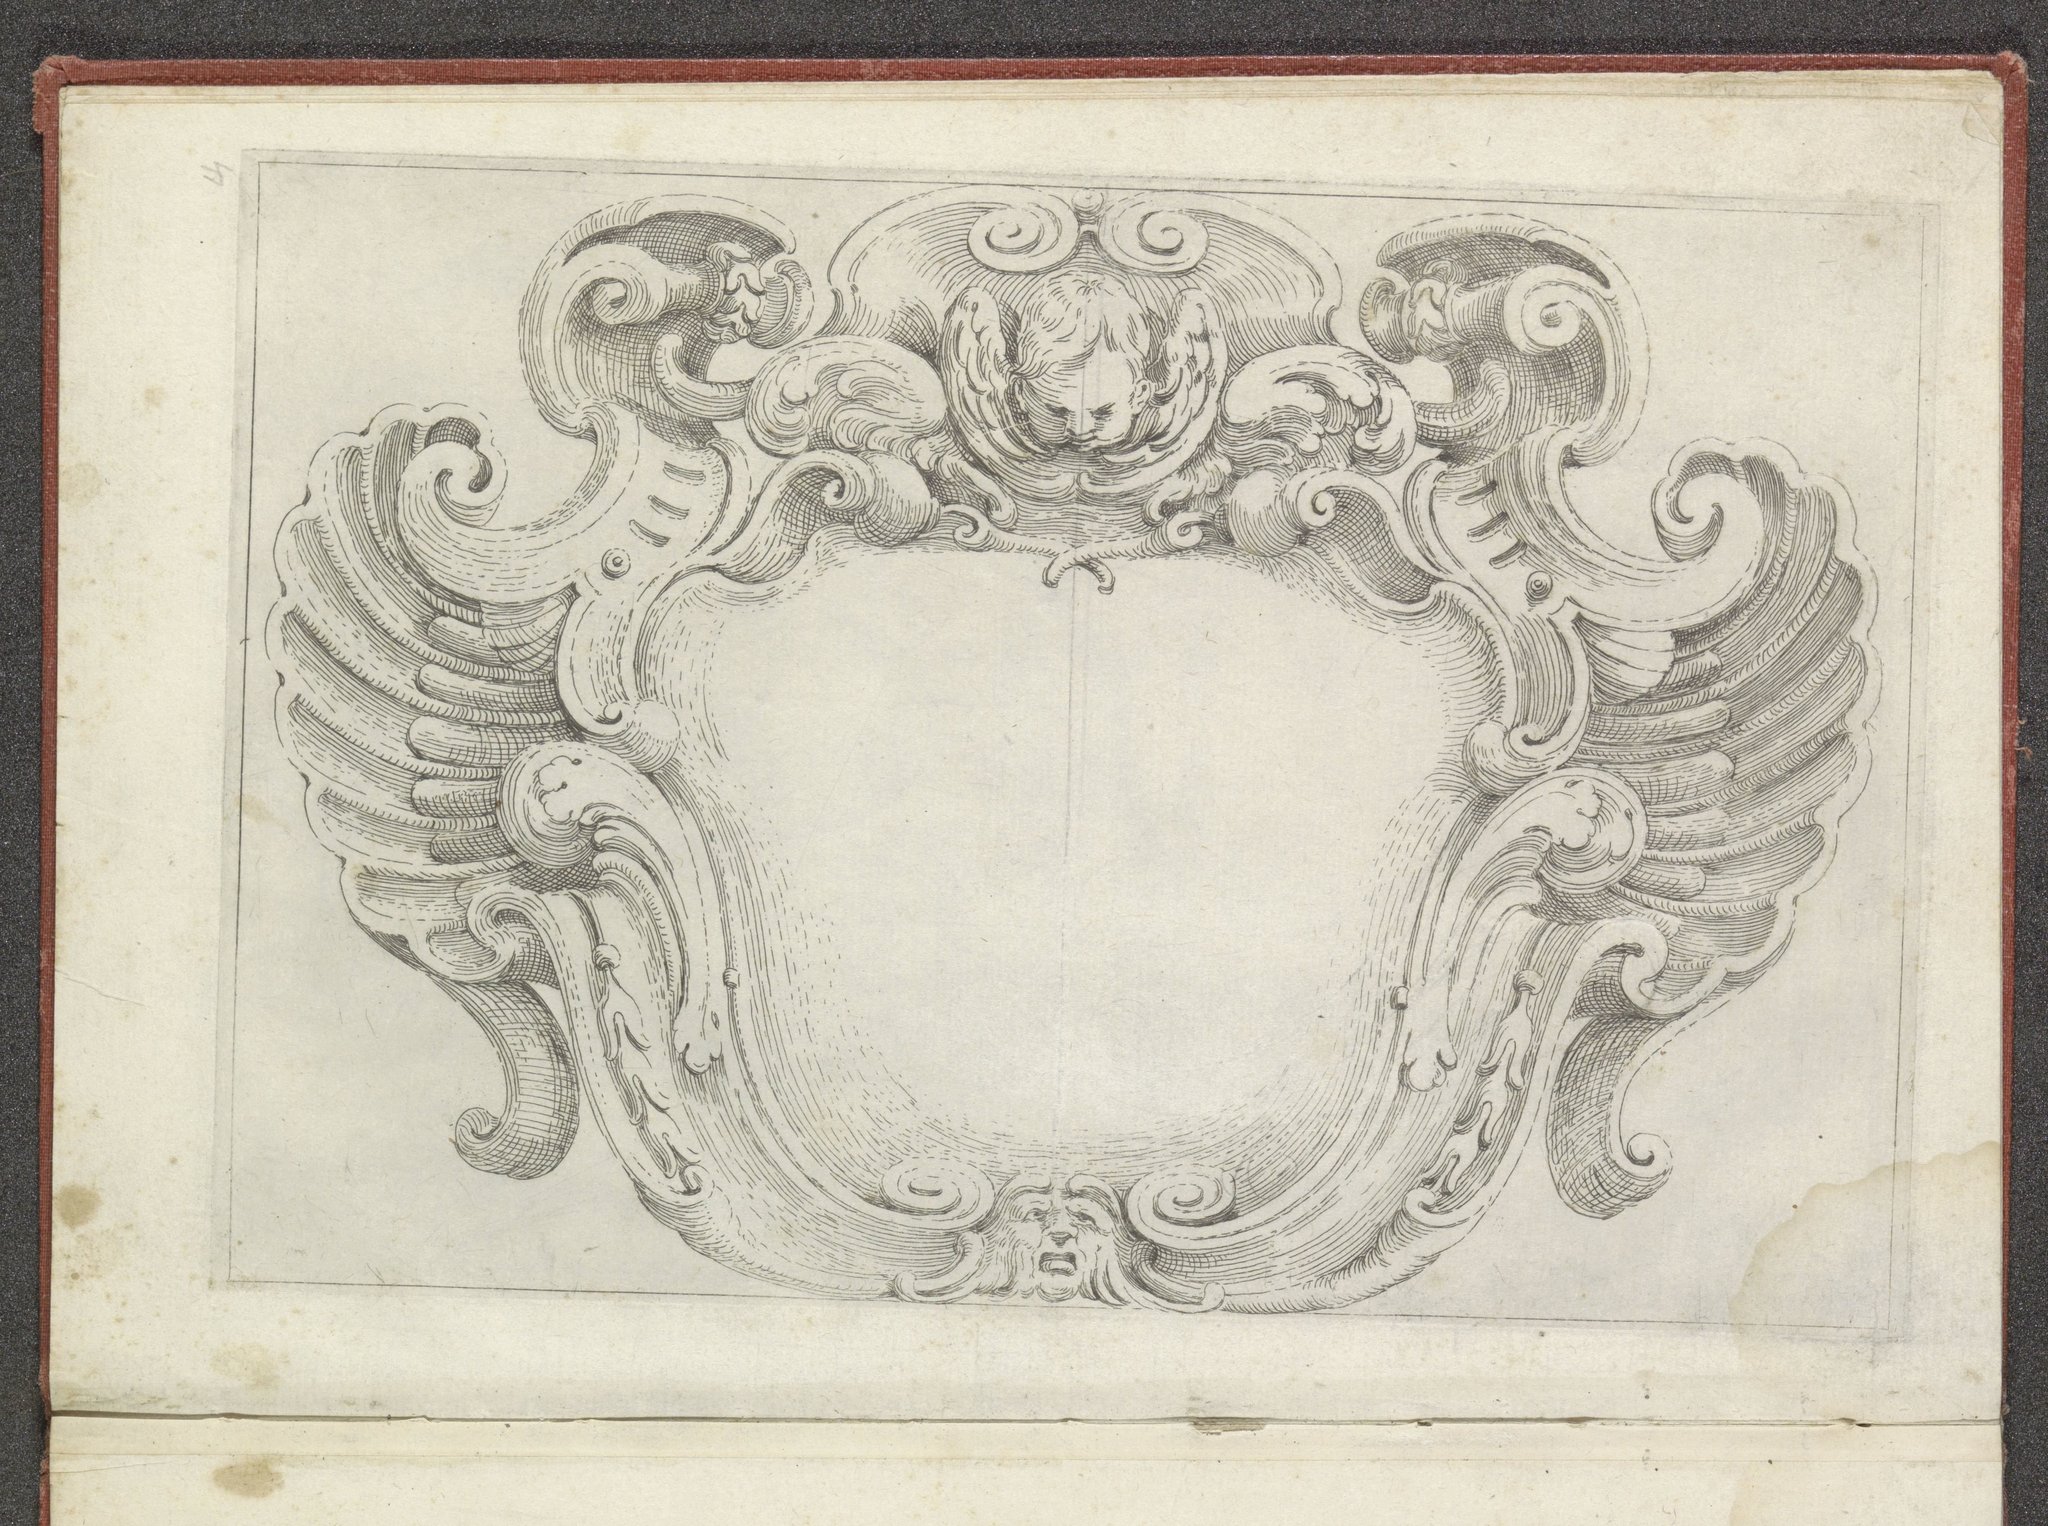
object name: album leaf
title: Cartouches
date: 1636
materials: paper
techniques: etching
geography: bologna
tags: cherubs, i.e. children's heads with wings, ornament ~ cartouche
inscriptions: collector's mark: Lugt 2760, collector's mark: Lugt 2228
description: Een cartouche met in de rand een cherubijn en een fantasiekop. De prent maakt deel uit van een album.